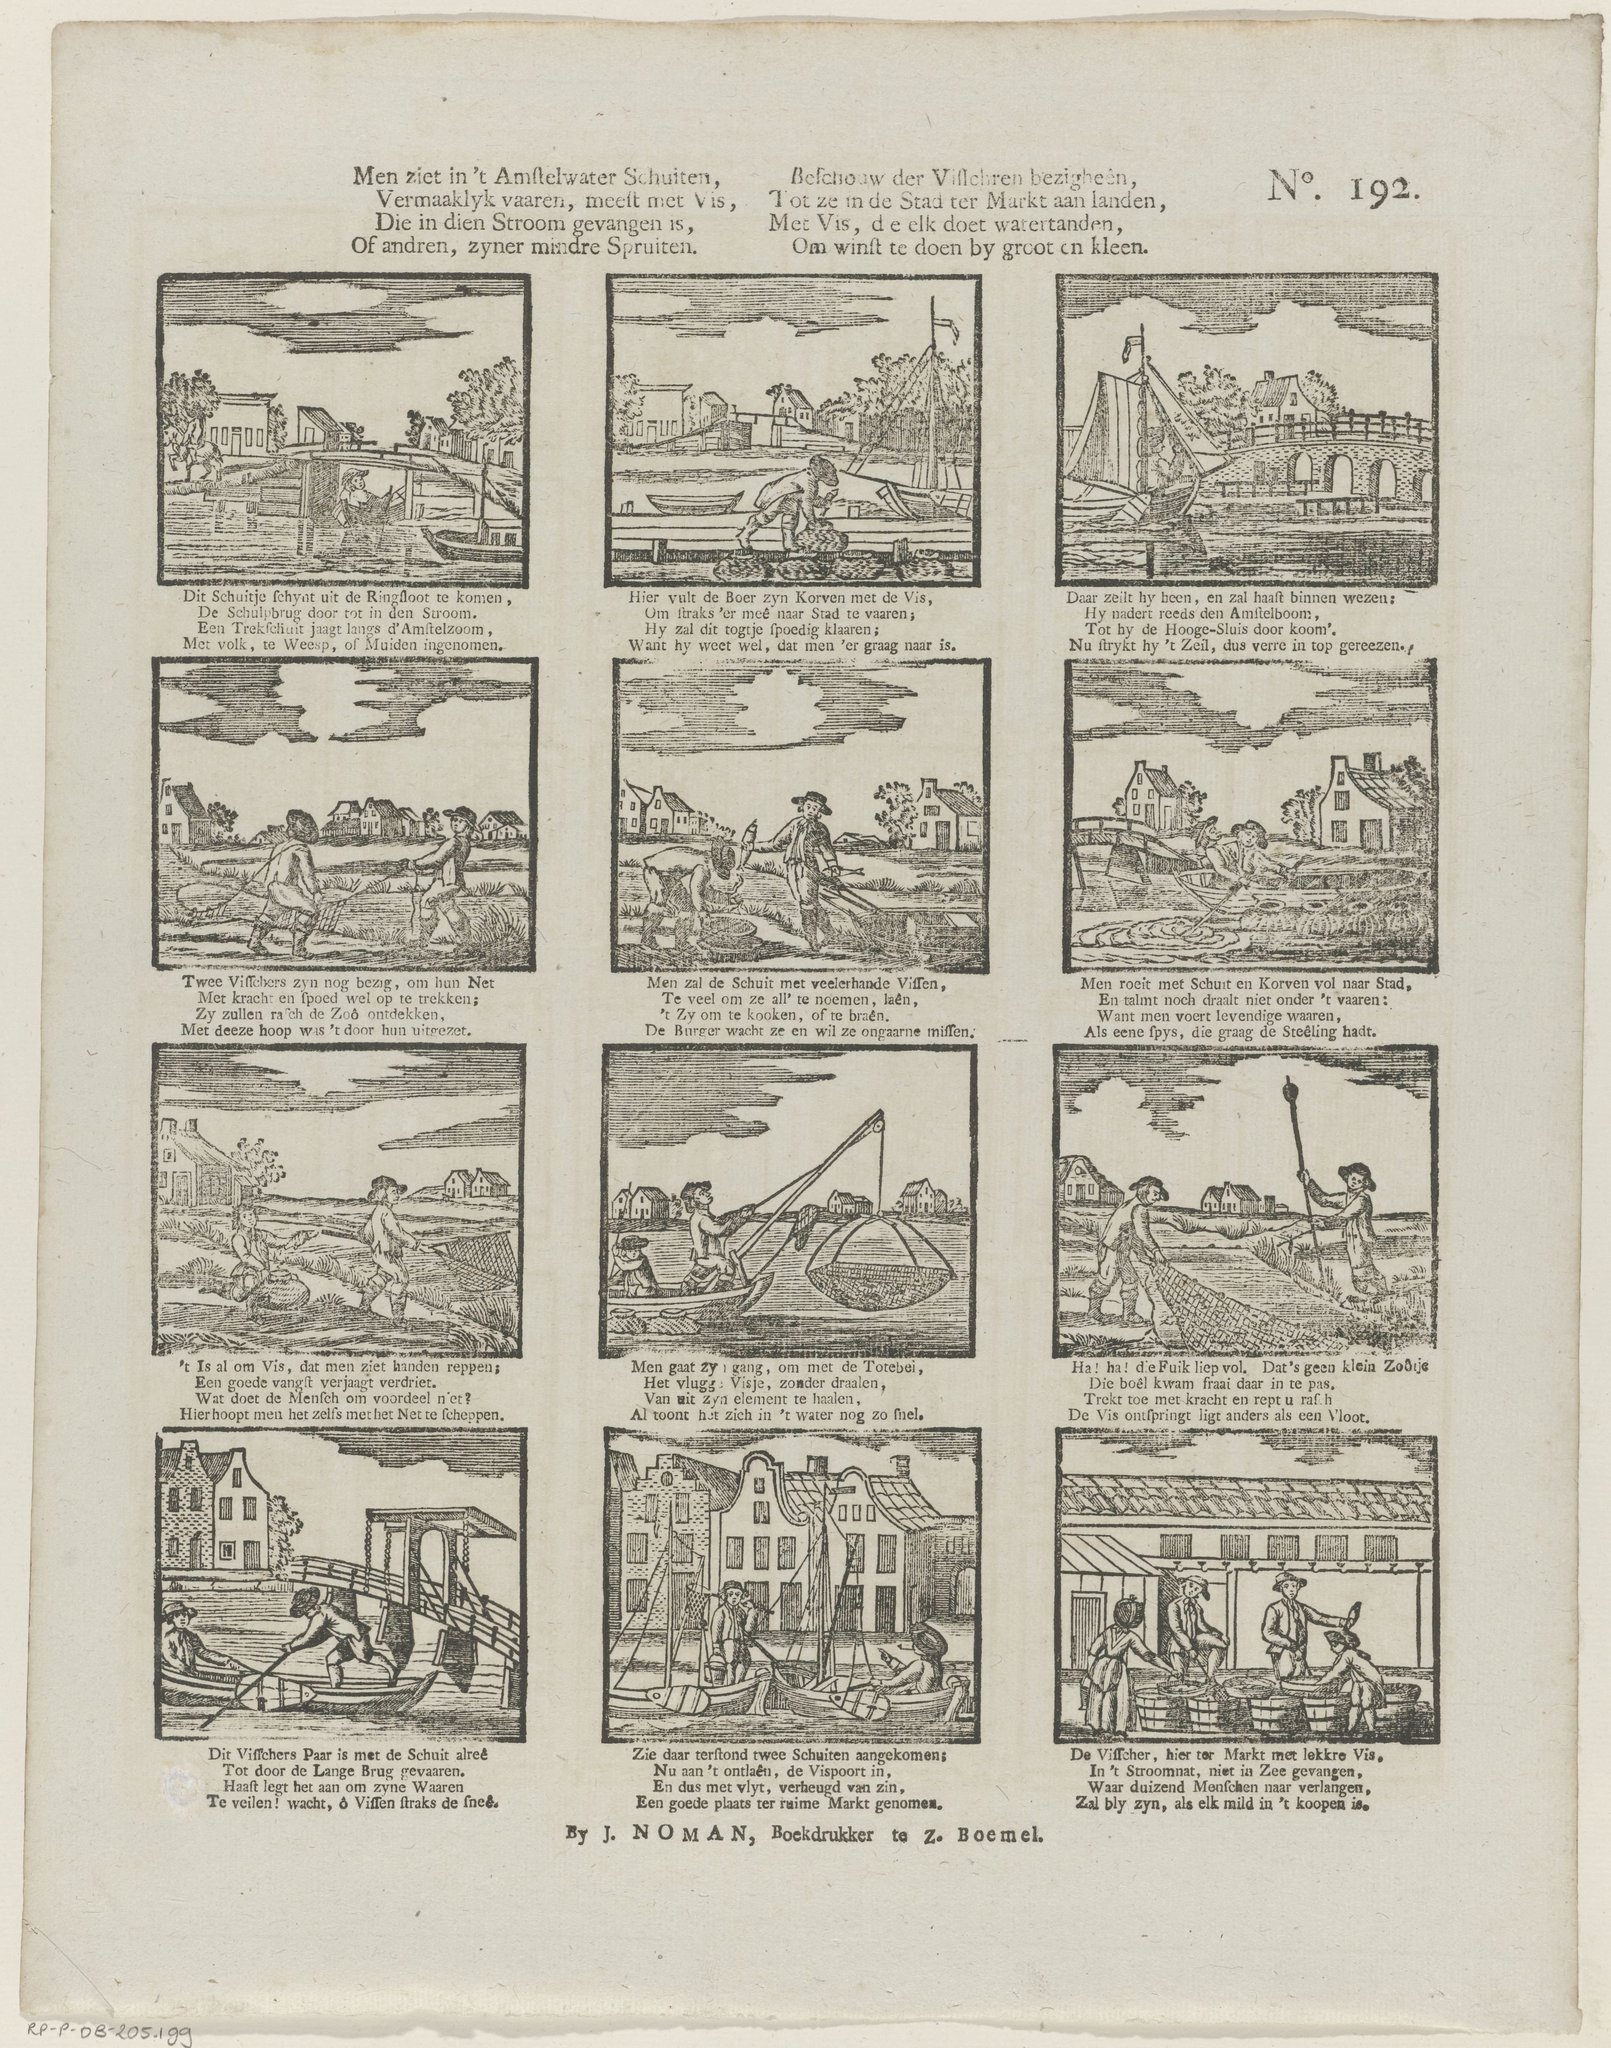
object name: print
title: Men ziet in 't Amstelwater schuiten, / Vermaaklyk vaaren, meest met vis [(...)]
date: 1806-1830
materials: paper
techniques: letterpress printing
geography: netherlands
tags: commercial fishery, fishing net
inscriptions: collector's mark: Lugt 2760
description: Blad met 12 voorstellingen van het visserijbedrijf in de Amstel. Onder elke afbeelding een vierregelig vers. Genummerd rechtsboven: No. 192.